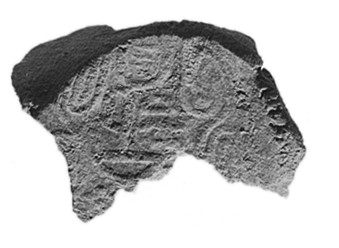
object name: sealing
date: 2030-1640 BCE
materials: clay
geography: egypt